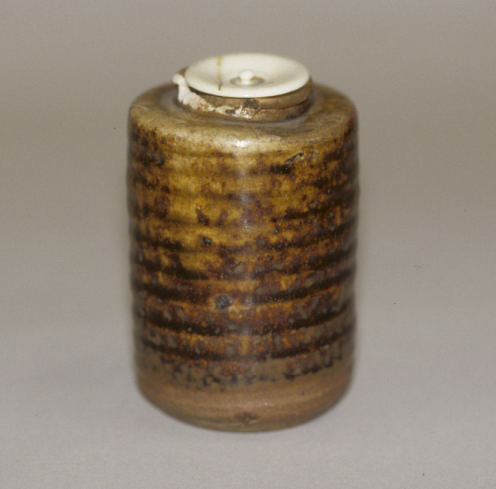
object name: tea jar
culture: japanese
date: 1701-1800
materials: clay, glaze